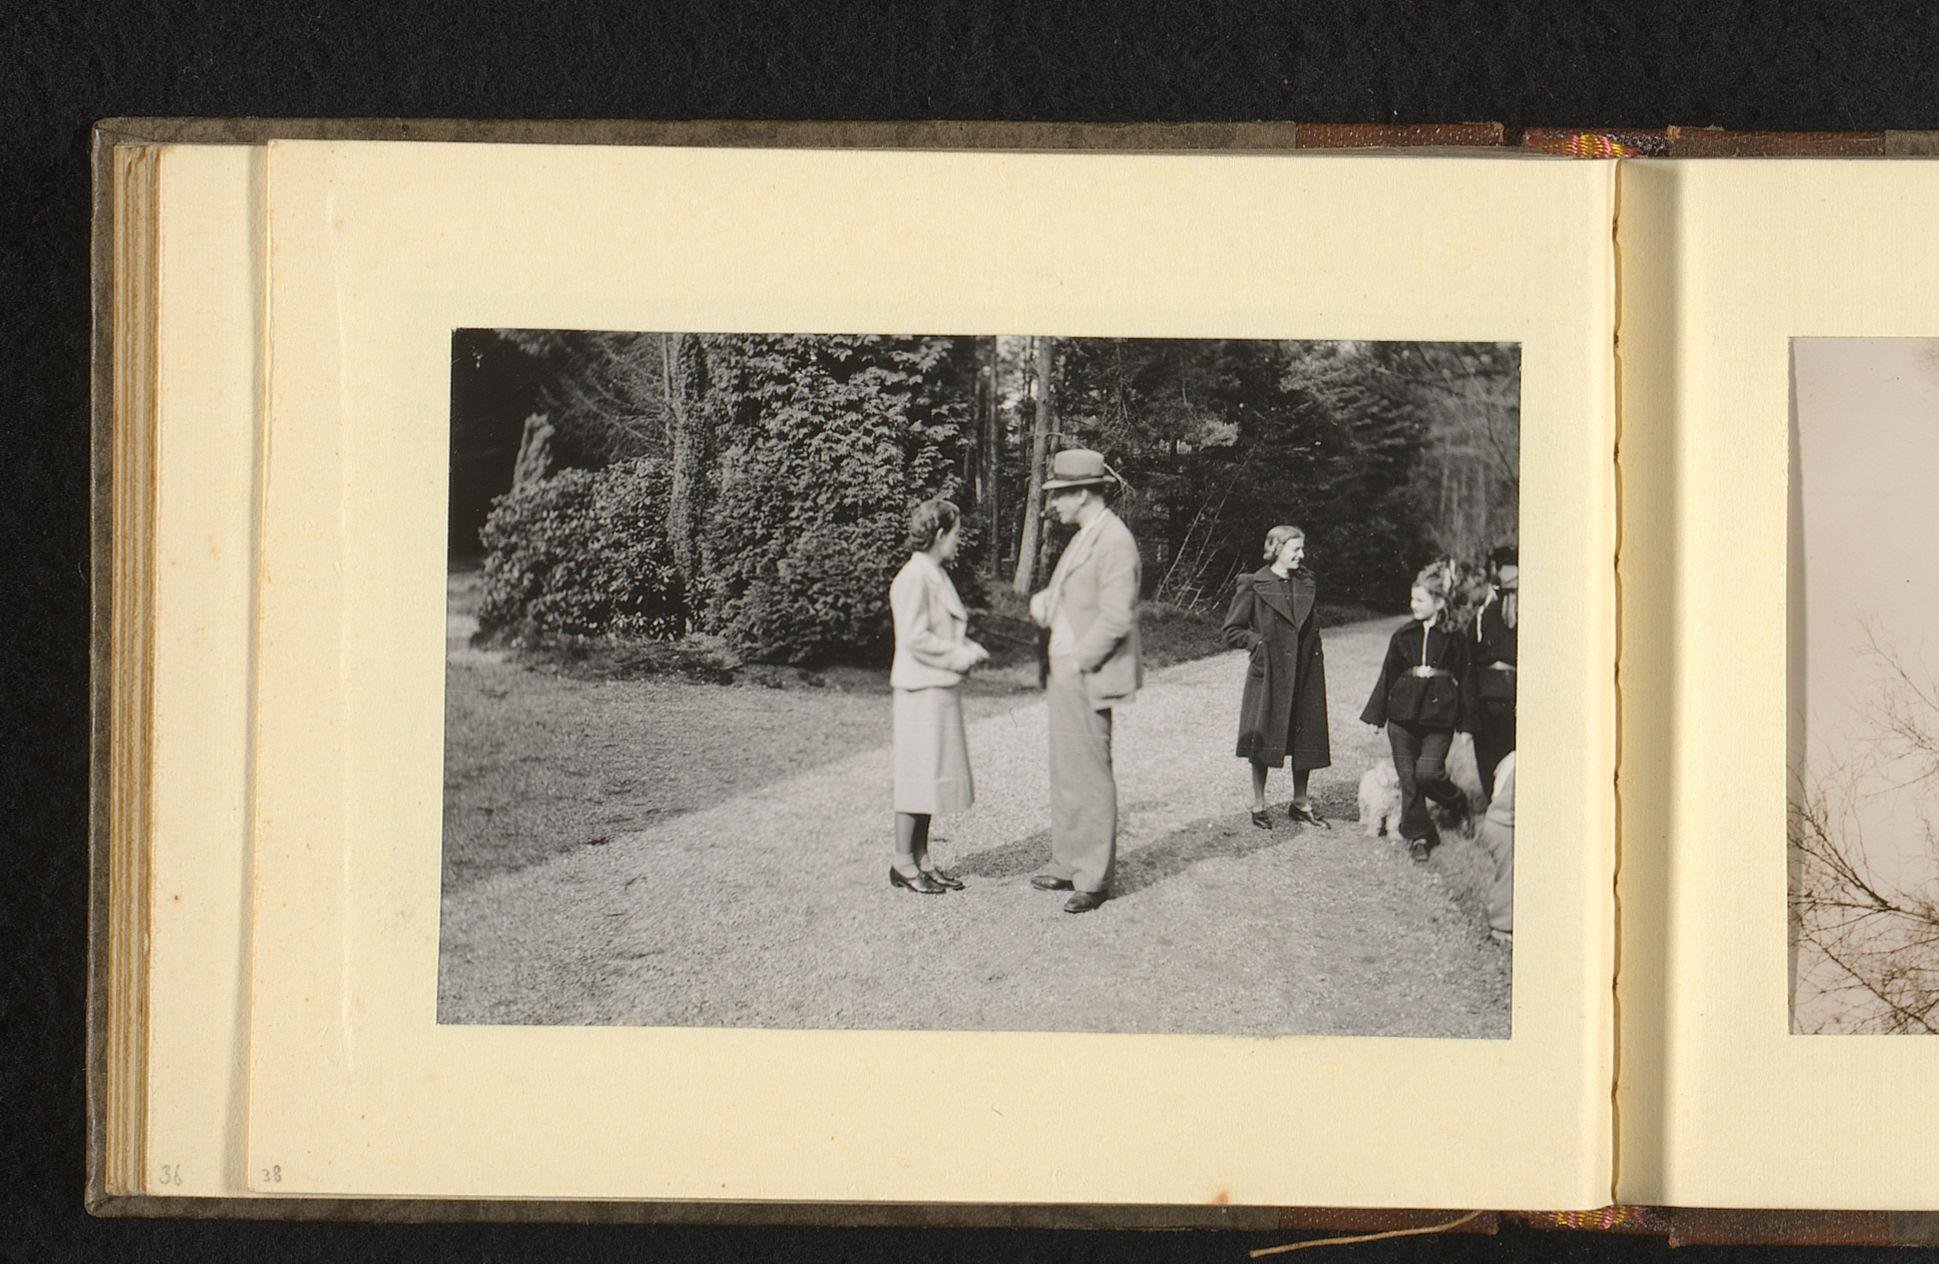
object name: photograph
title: Mensen op een grindpad in een tuin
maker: norbert van den berg (1901-1972)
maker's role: amateurfotograaf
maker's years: 1901-1972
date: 1935-1950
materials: paper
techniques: gelatin silver print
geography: netherlands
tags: garden, road, path